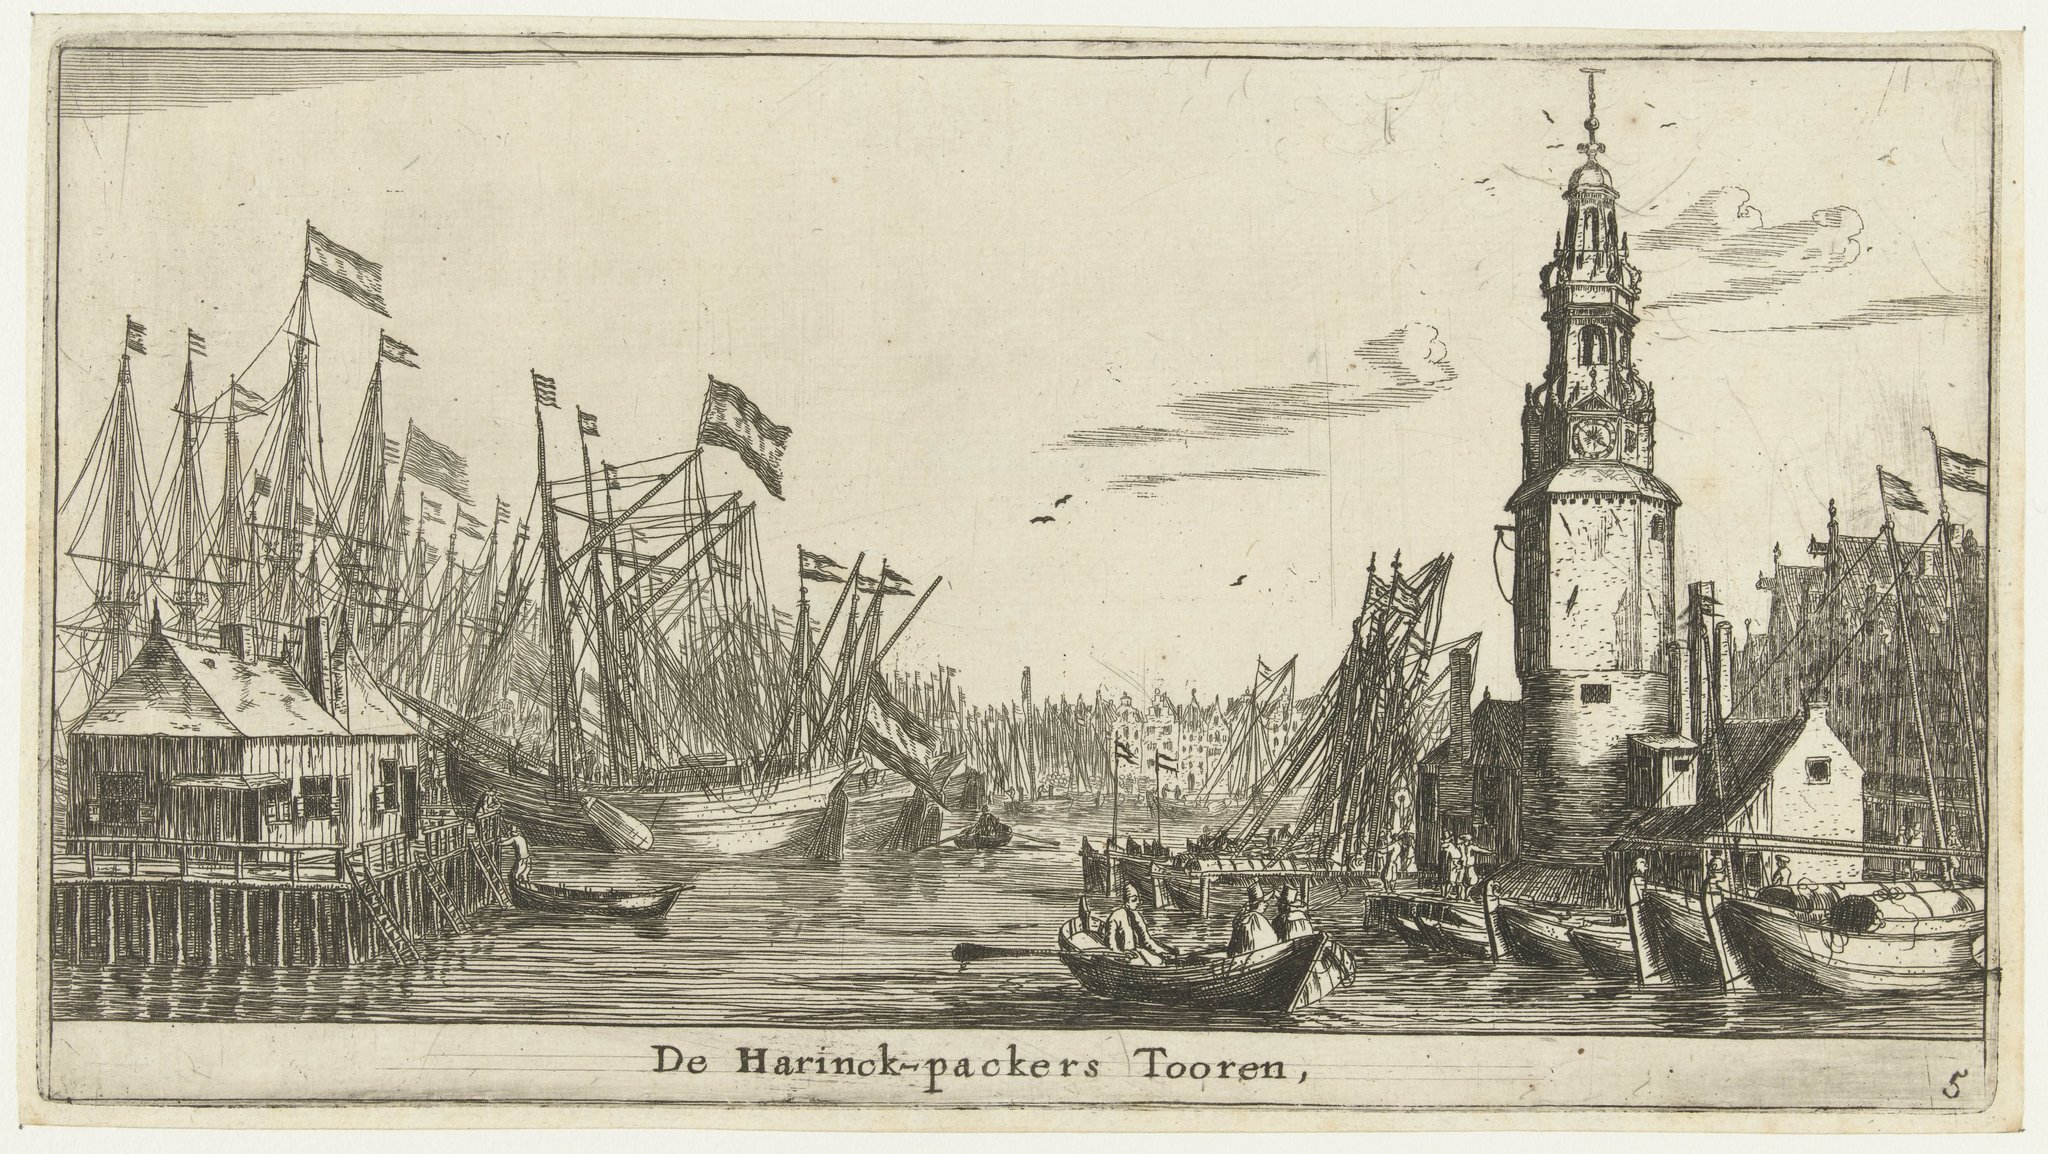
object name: print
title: Eerste deel. Verscheÿde schepen en gesichten van Amstelredam, naer t leven afgetekent en opt cooper gebracht, door Reinier Nooms, alÿas Zeeman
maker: reinier nooms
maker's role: draughtsman, painter, print maker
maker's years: 1623-1664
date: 1652-1654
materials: paper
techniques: drypoint, etching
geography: netherlands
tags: city-view in general; 'veduta'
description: Havenfront met vele aangemeerde zeilschepen. Links de oude Stadsherberg, rechts de Haringpakkerstoren en de huizen aan de Haringpakkerij, tegenwoordig de Prins Hendrikkade.